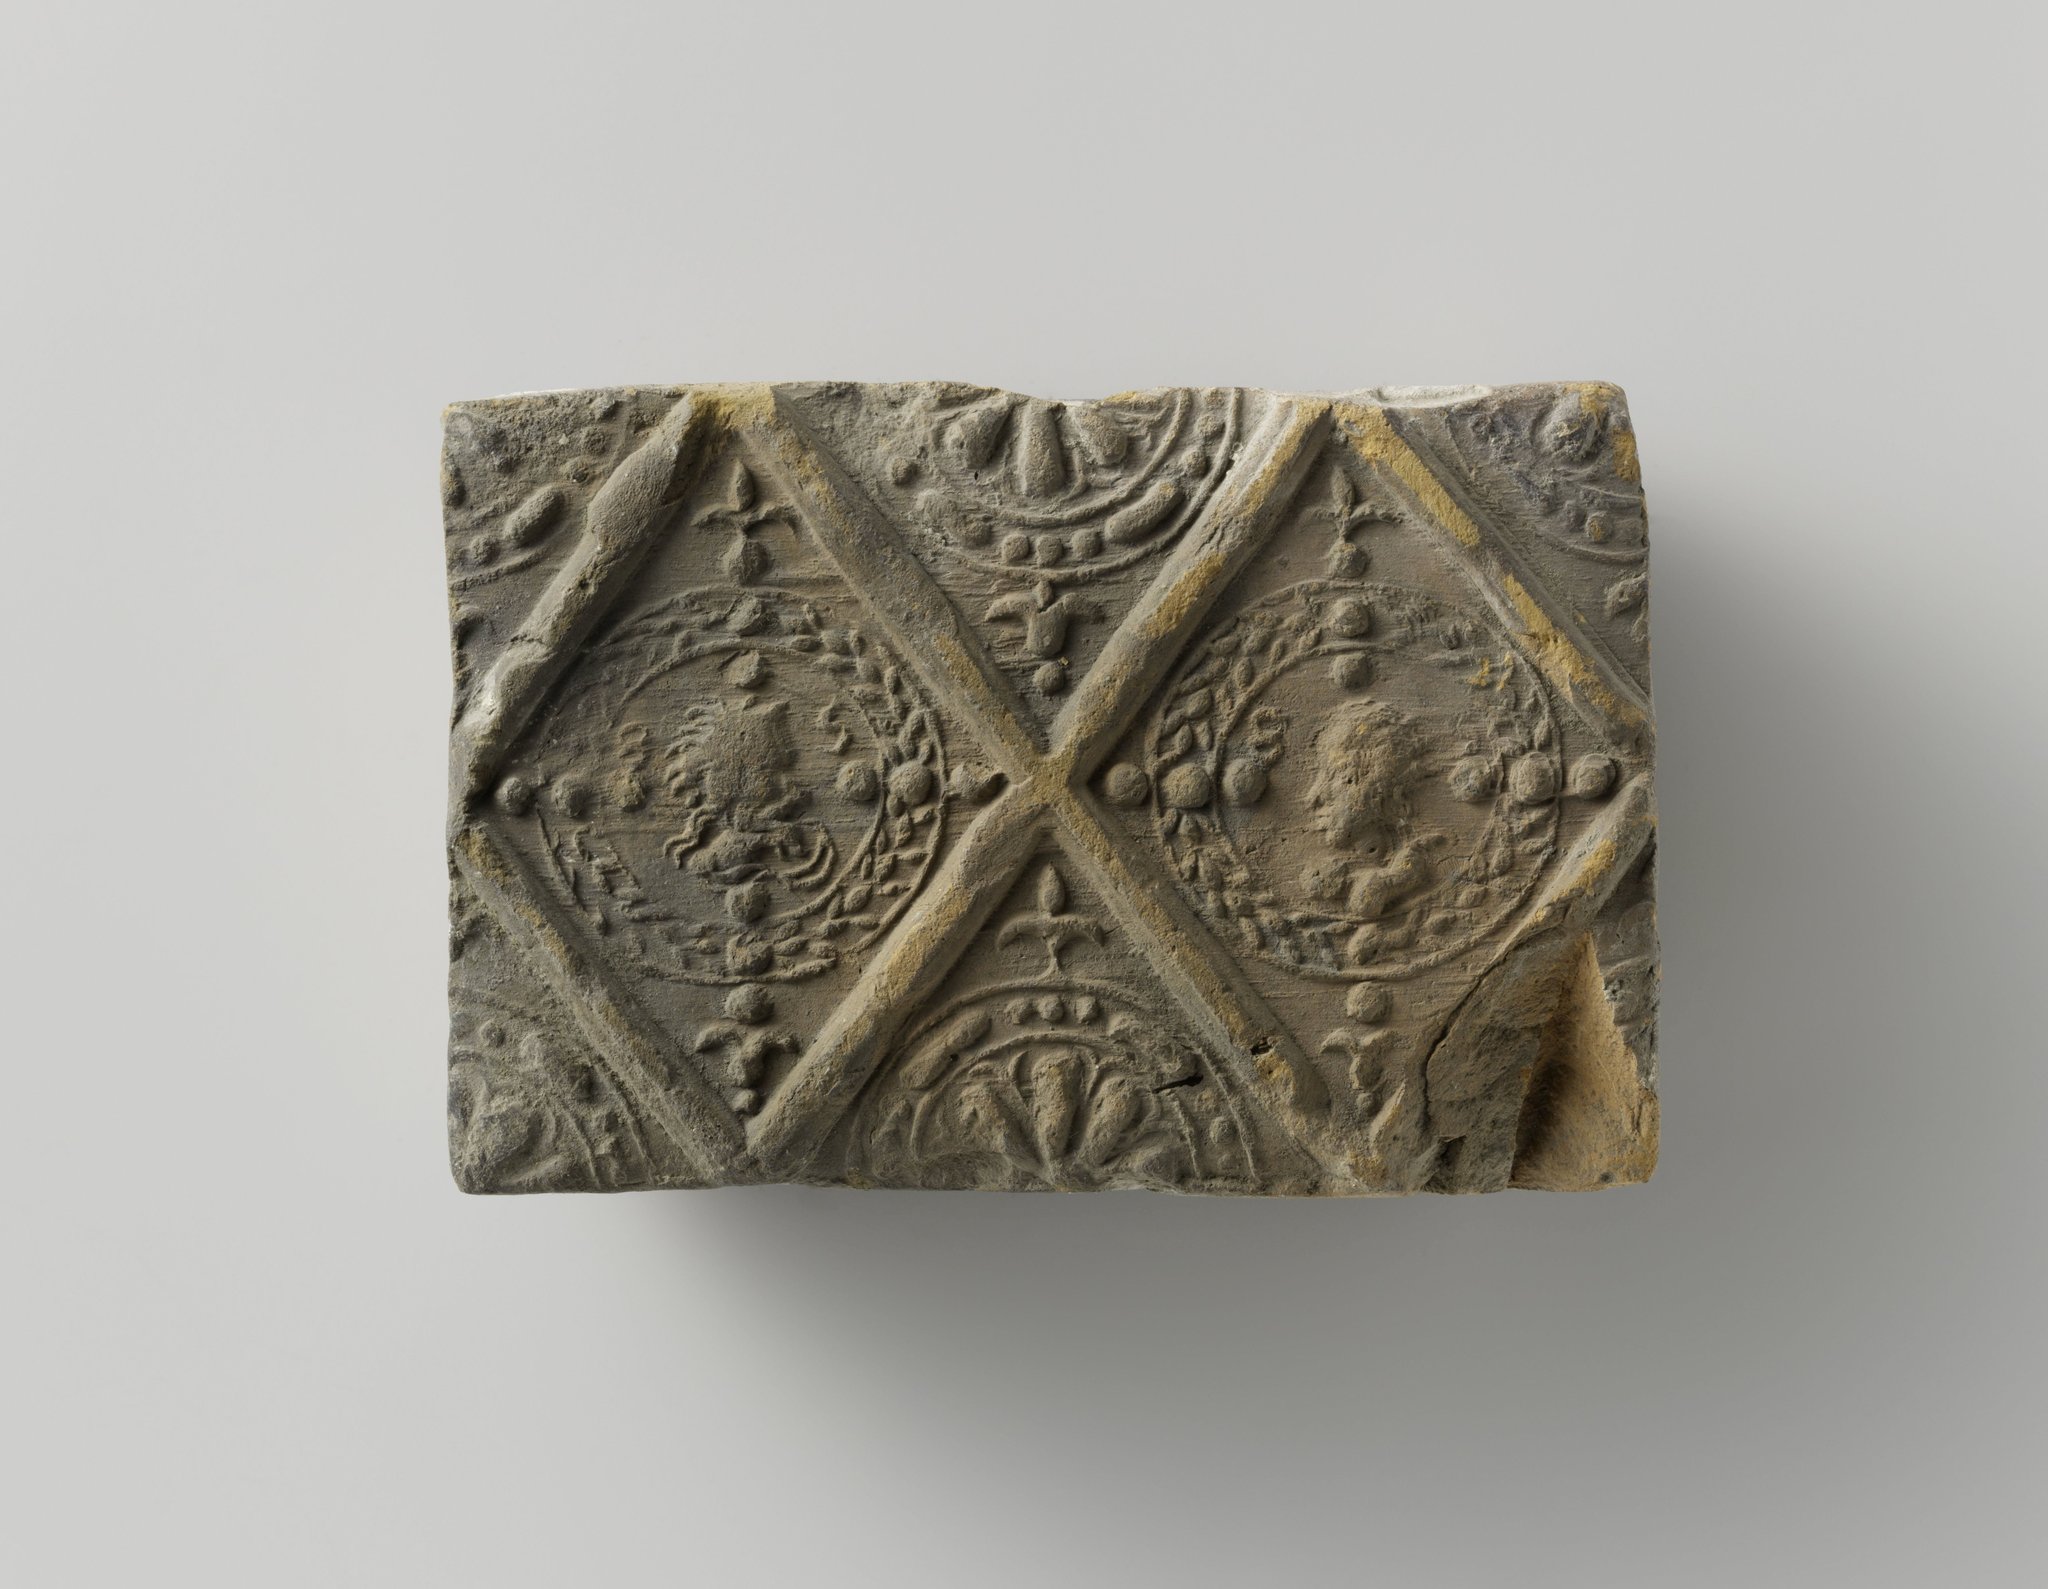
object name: architectural element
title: Gebakken haardsteen, met ruiten met daarin bustes in medaillons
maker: Anonymous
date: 1585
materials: earthenware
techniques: firing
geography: southern netherlands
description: Gebakken haardsteen, met ruiten met daarin bustes in medaillons.